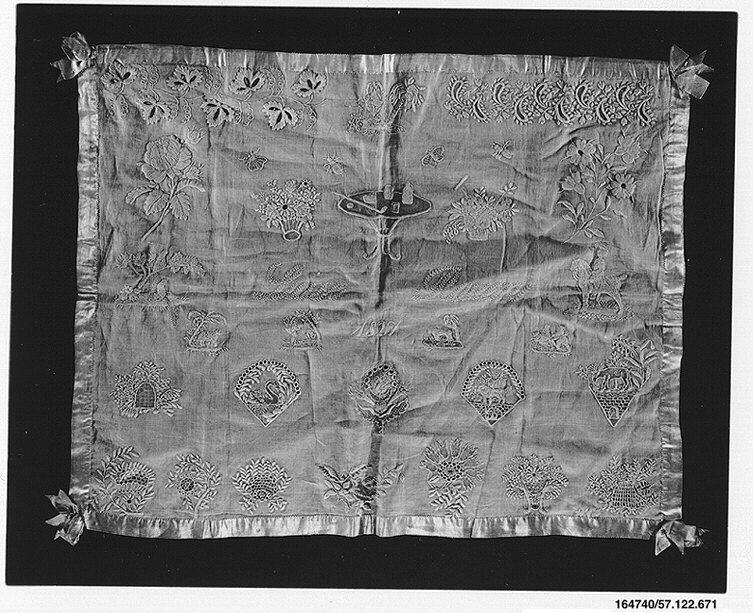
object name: sampler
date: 1827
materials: cotton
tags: animals,roses